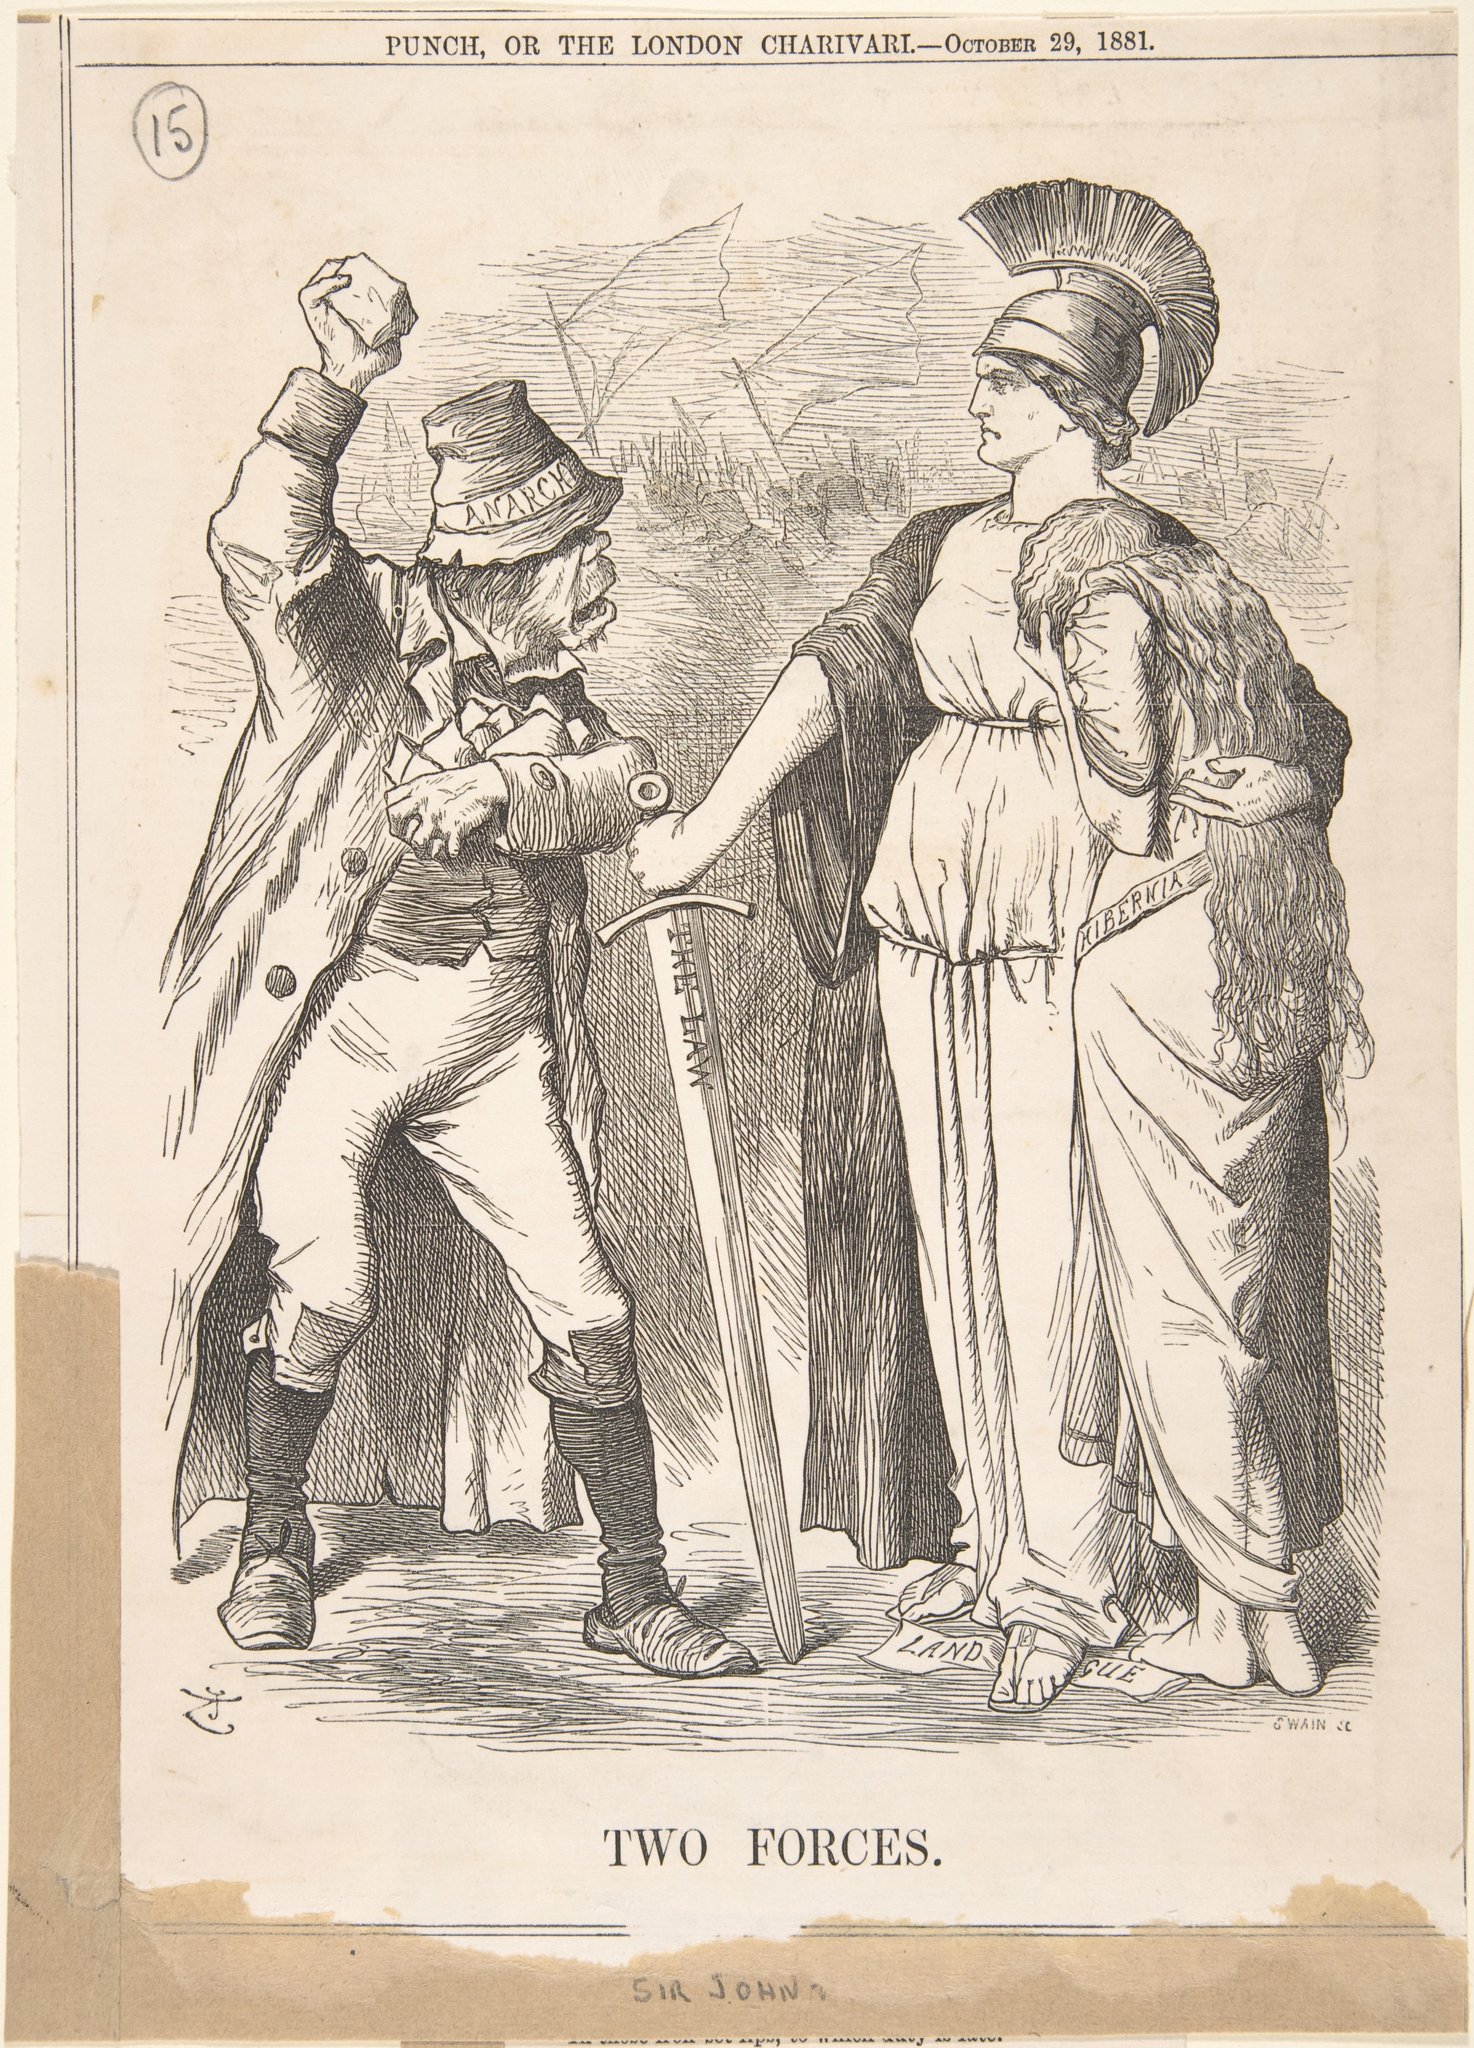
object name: print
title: Two Forces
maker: sir john tenniel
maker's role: artist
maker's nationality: british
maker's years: 1820-1914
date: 1881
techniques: engraving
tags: men,women